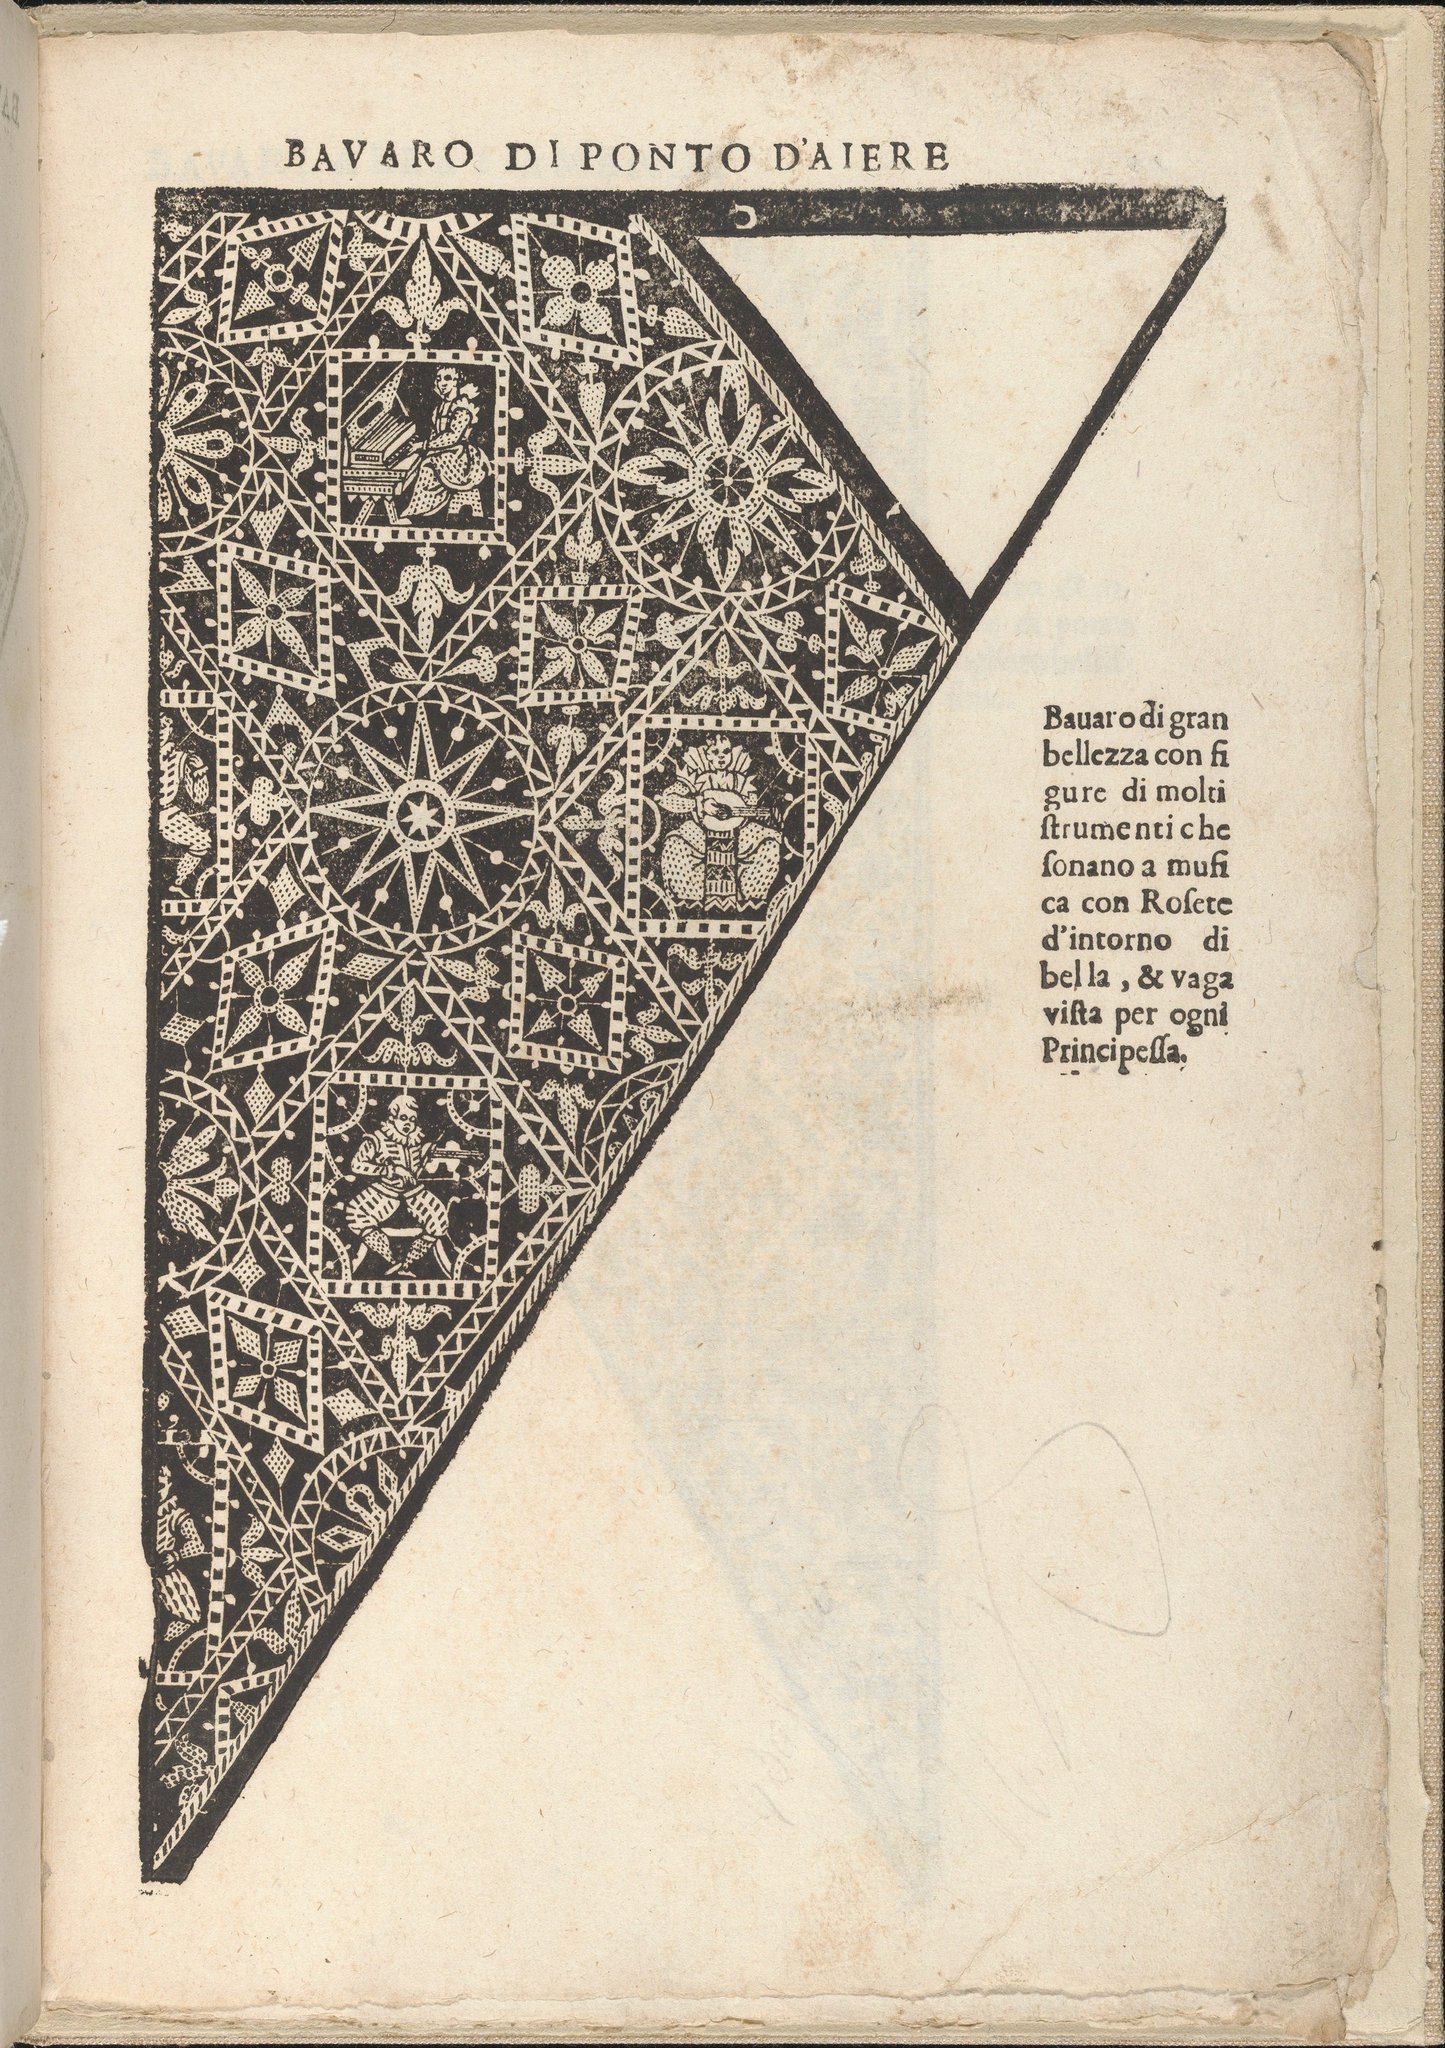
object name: book print ornament architecture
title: Ornamento nobile...Fatta da Lucretia Romana (Libro V of the Corona), page 11 (recto)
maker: cesare vecellio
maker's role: author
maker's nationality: italian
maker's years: 1521-1601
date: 1620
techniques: woodcut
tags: ornament